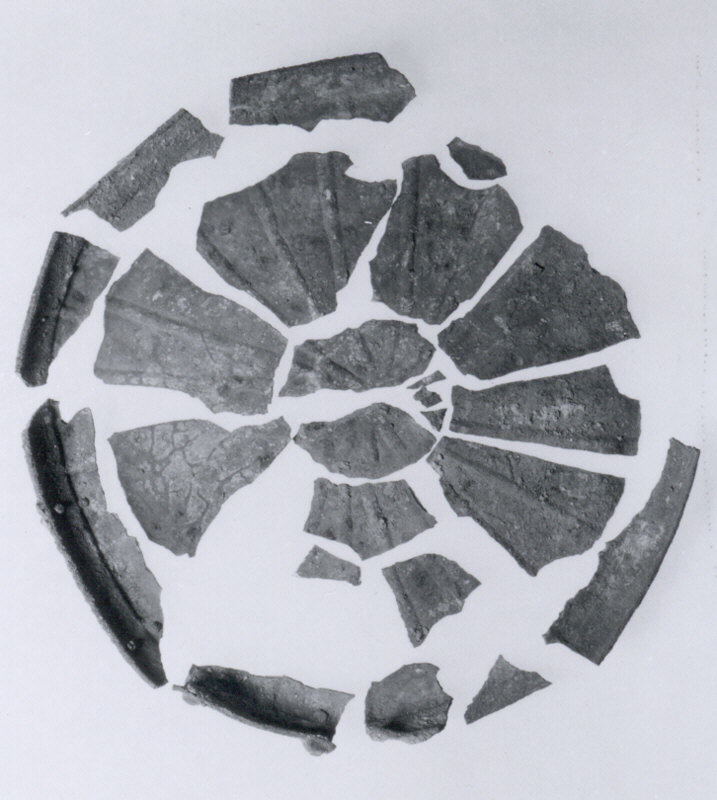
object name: basin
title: Basin fragments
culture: iranian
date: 900-801 BCE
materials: bronze, iron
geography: iran